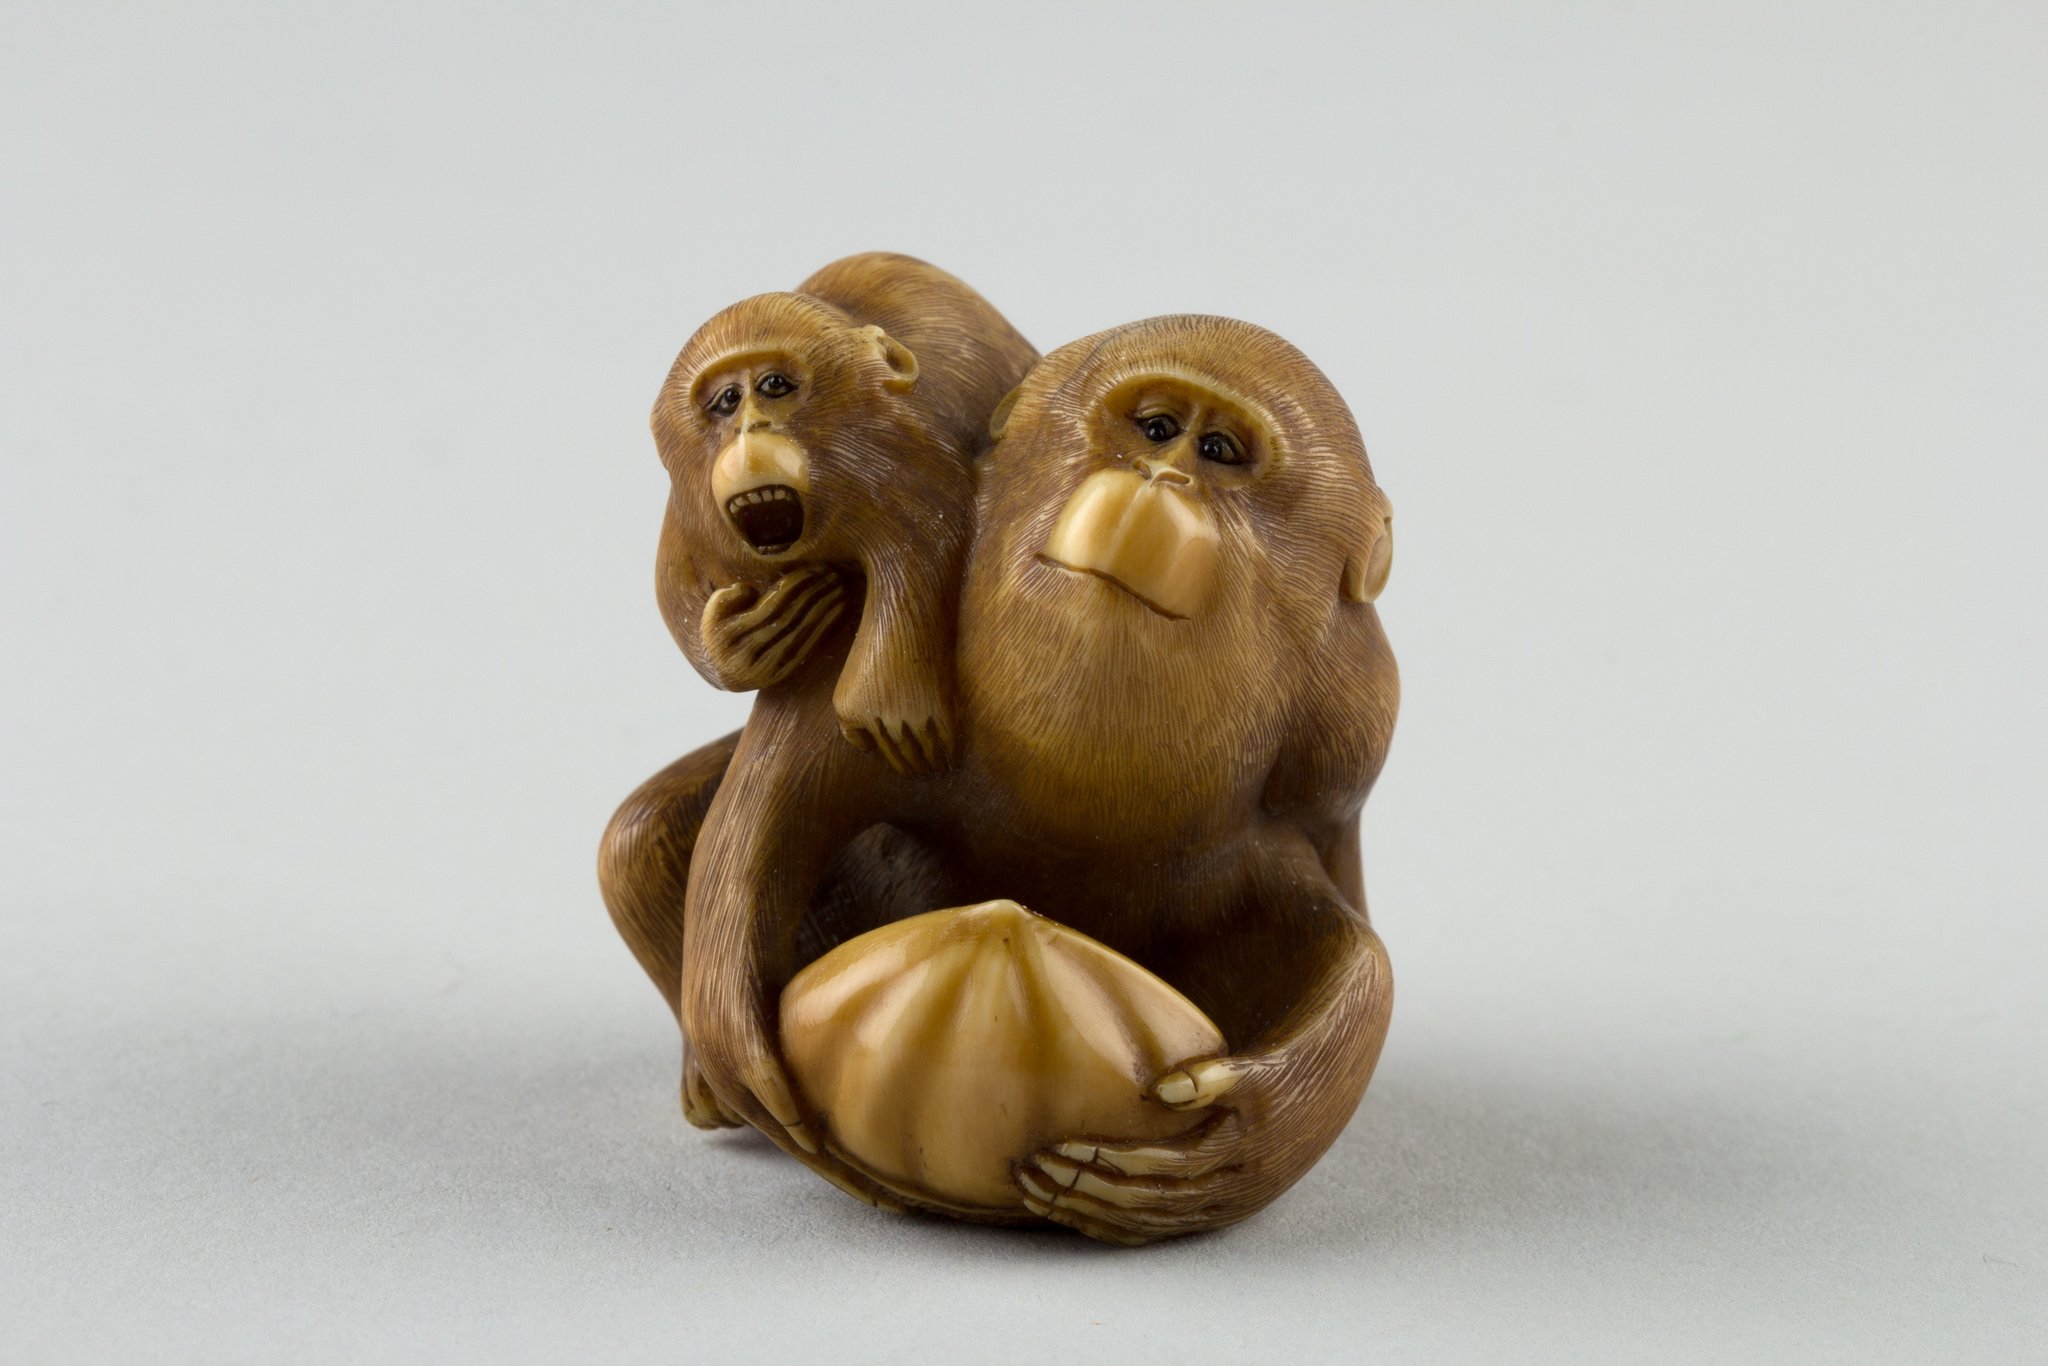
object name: netsuke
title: Netsuke of a Female Monkey Holding a Nut while her Baby Crawls on her Back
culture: japanese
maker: masatami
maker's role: artist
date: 1801-1900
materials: horn, ivory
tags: monkeys